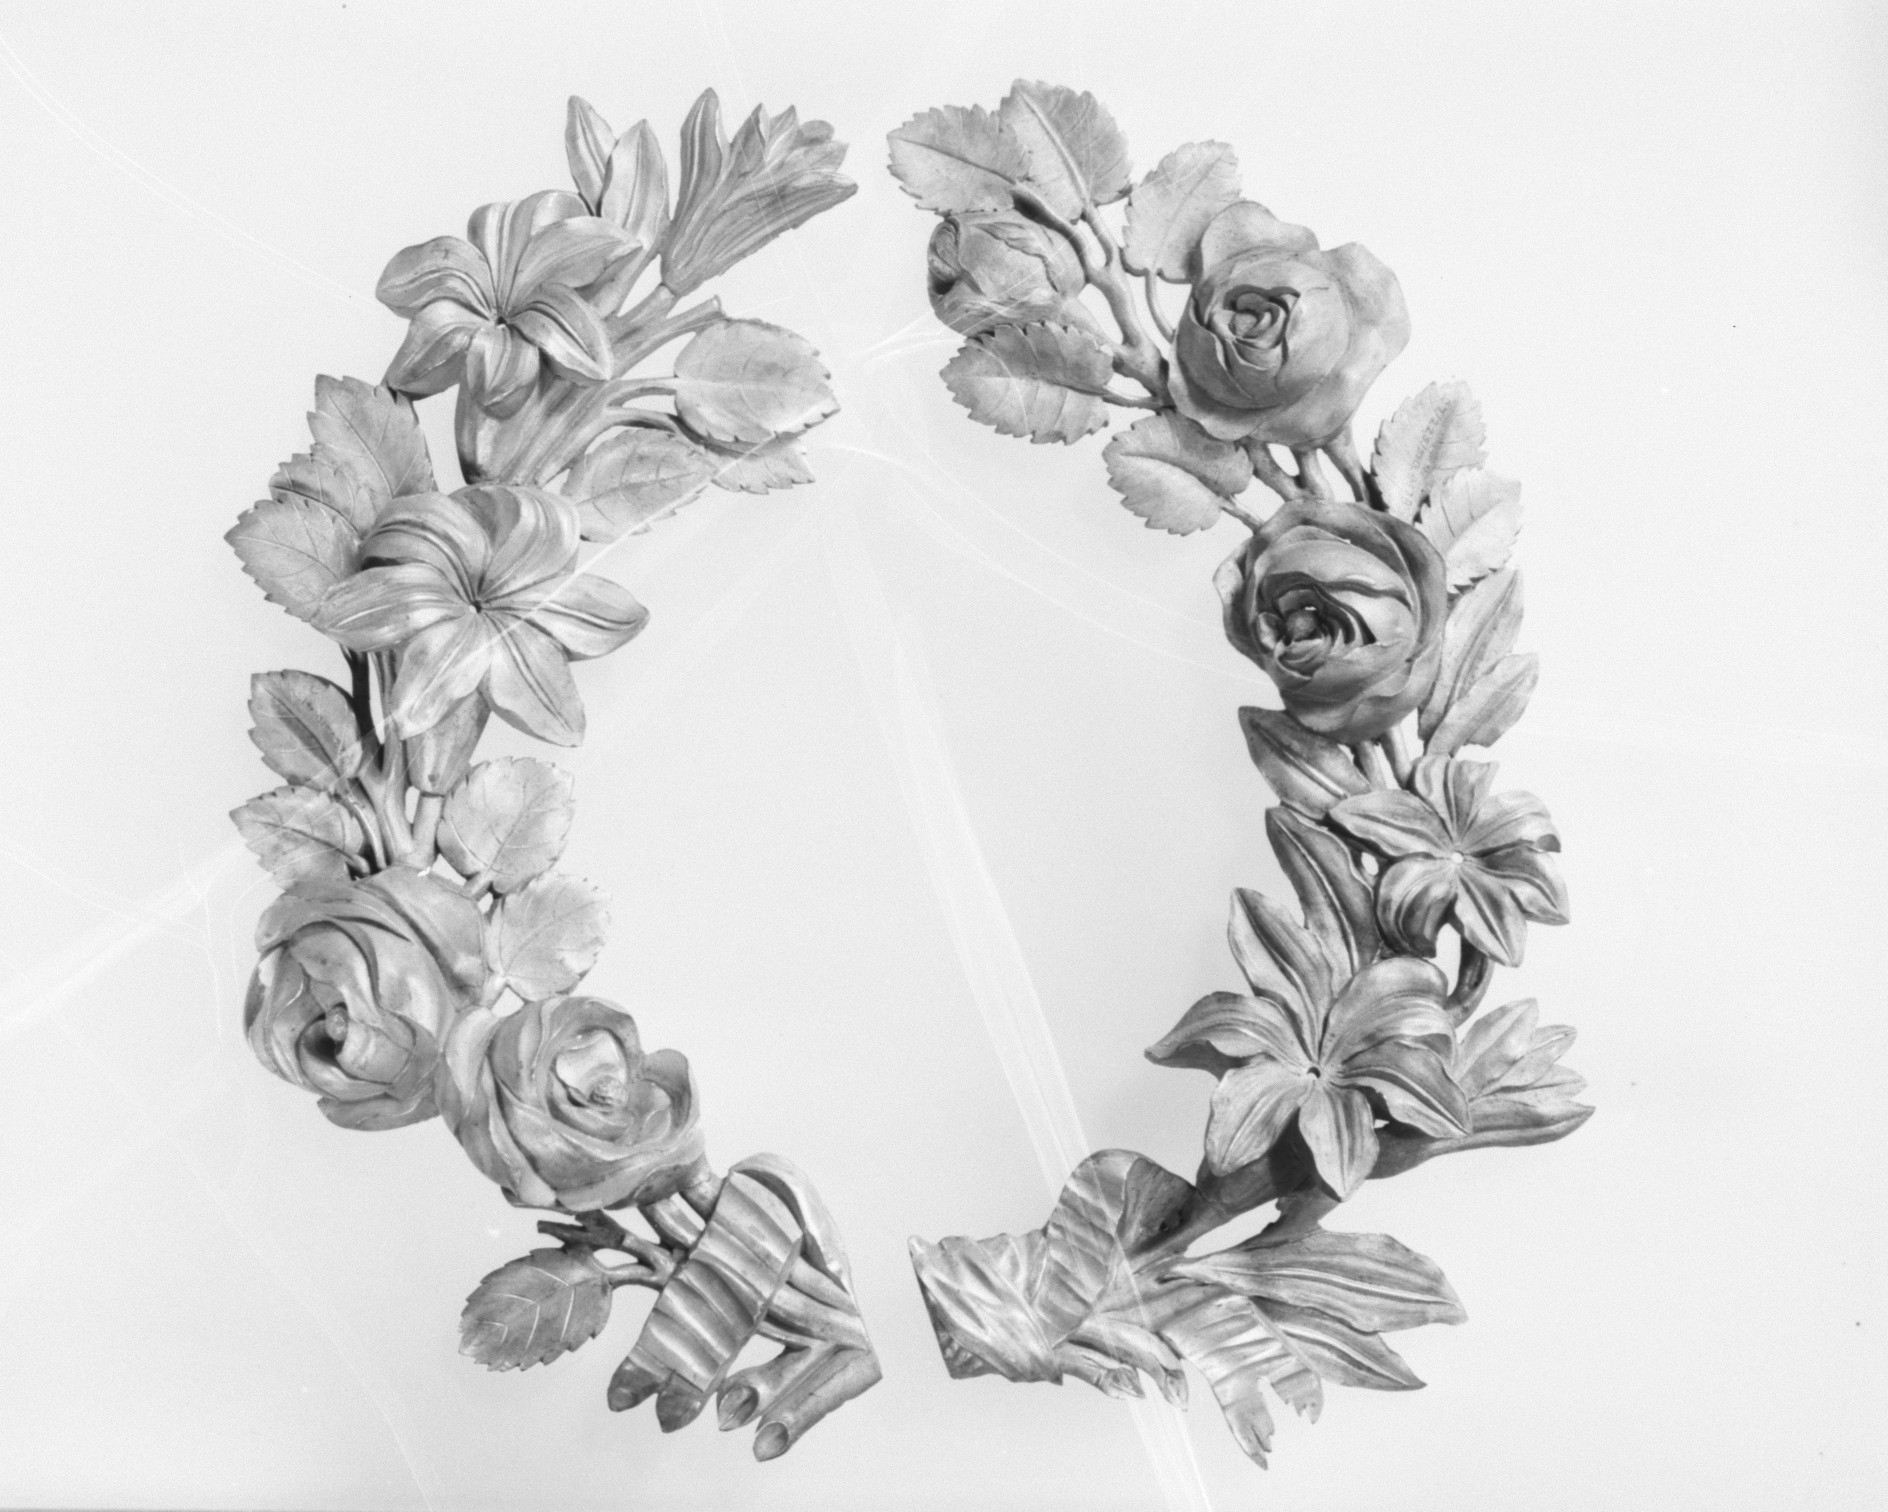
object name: wreath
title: Pair of wreaths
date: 1701-1800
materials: gilt bronze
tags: roses,leaves,wreaths